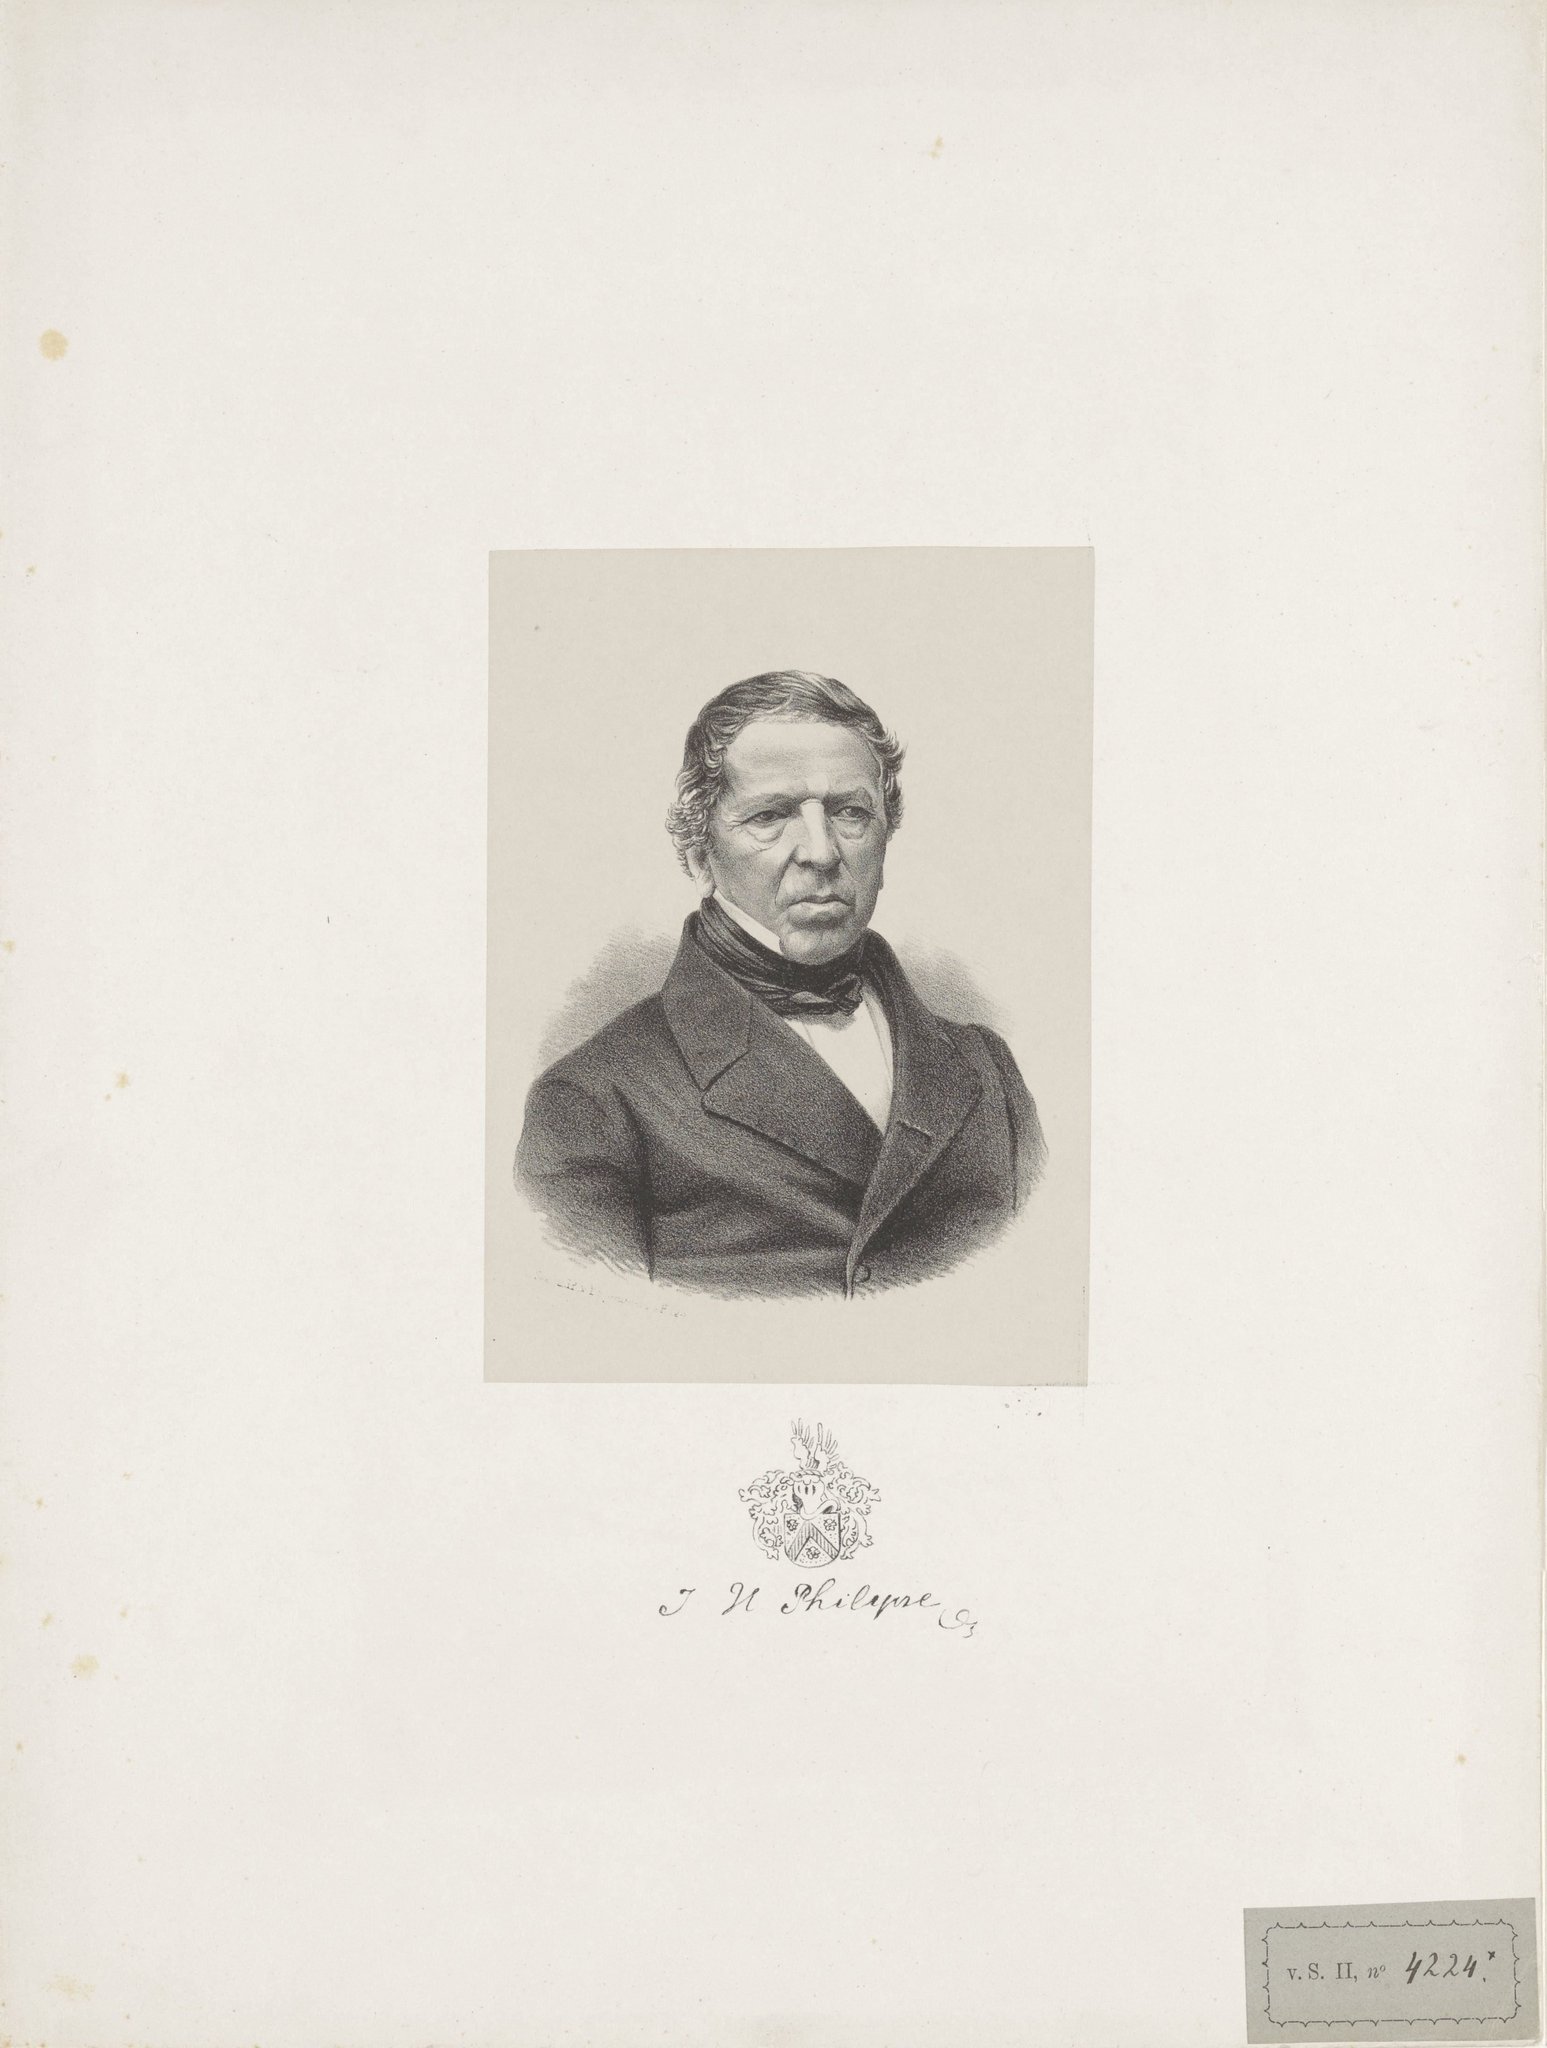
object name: print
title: Portret van Jacobus Hermannus Philipse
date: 1842-1887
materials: paper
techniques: lithograph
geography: the hague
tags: historical persons (+ (full) bust portrait), armorial bearing, heraldry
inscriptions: collector's mark: Lugt 2228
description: De geportretteerde draagt een cravate. Onder het portret zijn naam en familiewapen.